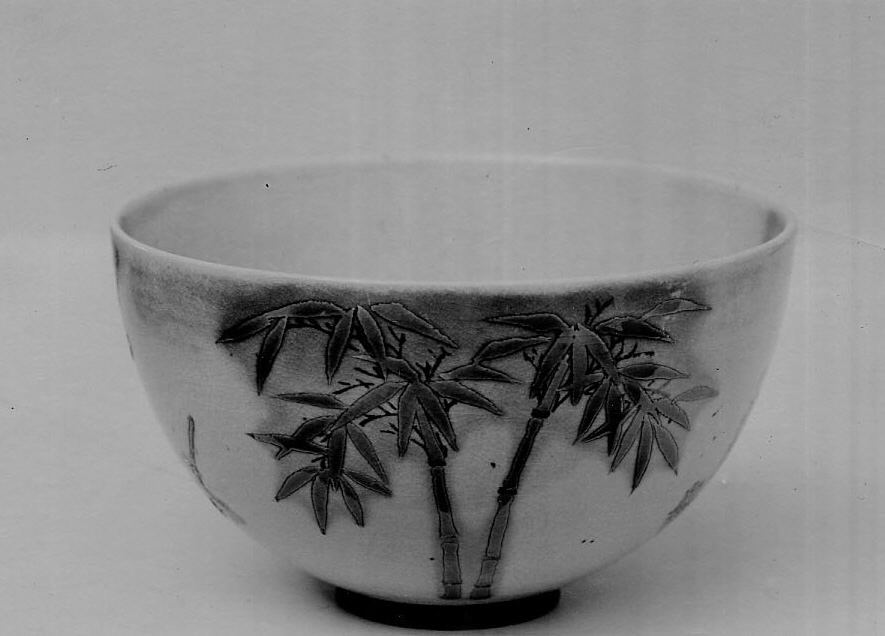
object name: bowl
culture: japanese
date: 1801-1900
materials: enamel, gold, pottery